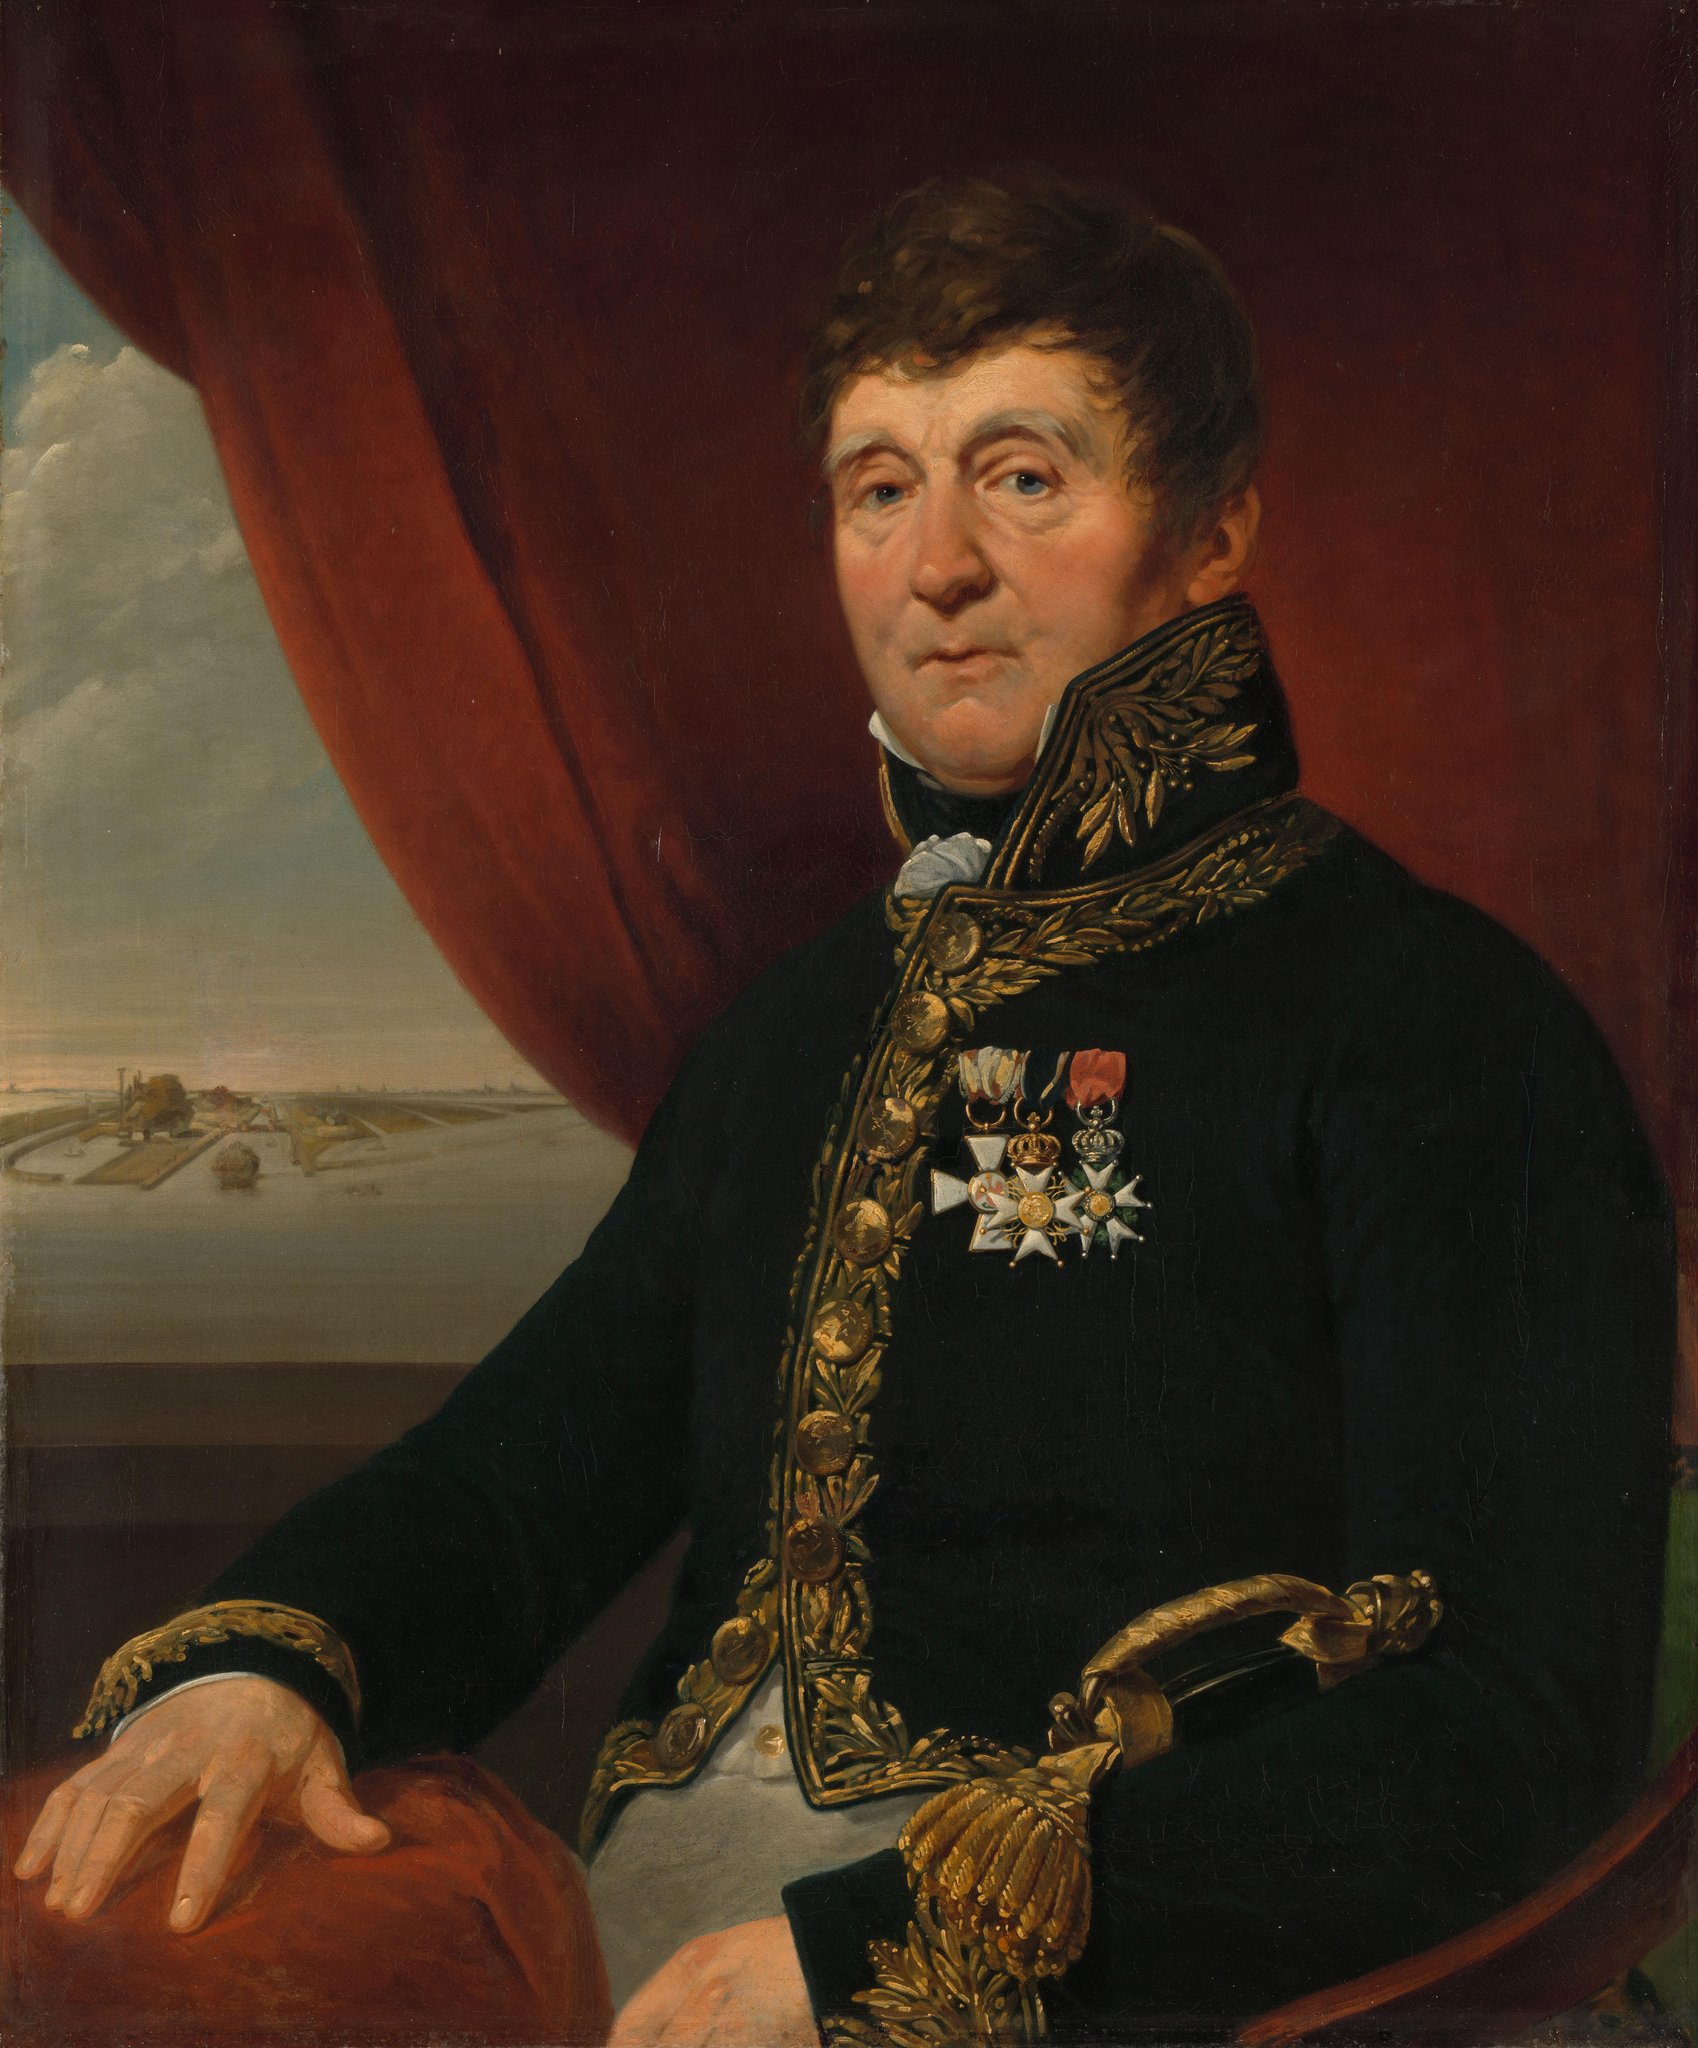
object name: painting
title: Jan Blanken Jansz., Superintendent of Waterworks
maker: jean augustin daiwaille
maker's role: draughtsman, print maker, printer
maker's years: 1786-1850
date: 1820-1838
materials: canvas, oil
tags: jan blanken jansz., historical persons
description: Jan Blanken, by J.A. Daiwaille, c. 1825. Hydraulic engineer Jan Blanken (1755-1838) played a key roll in the development of the Dutch water authority after 1800. Despite the political turmoil of those years, this was a period in which major projects were initiated. Under a succession of Dutch governments, Blanken supplied the country with docks, harbours, canals and fortifications. One of his best-known works is the North Holland canal, opened in 1824. In the painting in the background is the entrance to the canal, the Willem sluice at Amsterdam, named after the man who commissioned the work, King William I. Here Blanken is portrayed in his official uniform. Like Goudriaan, he was appointed inspector general of the water authority in 1808. Blanken supported the wearing of uniforms: the corps of engineers was organised along military lines.